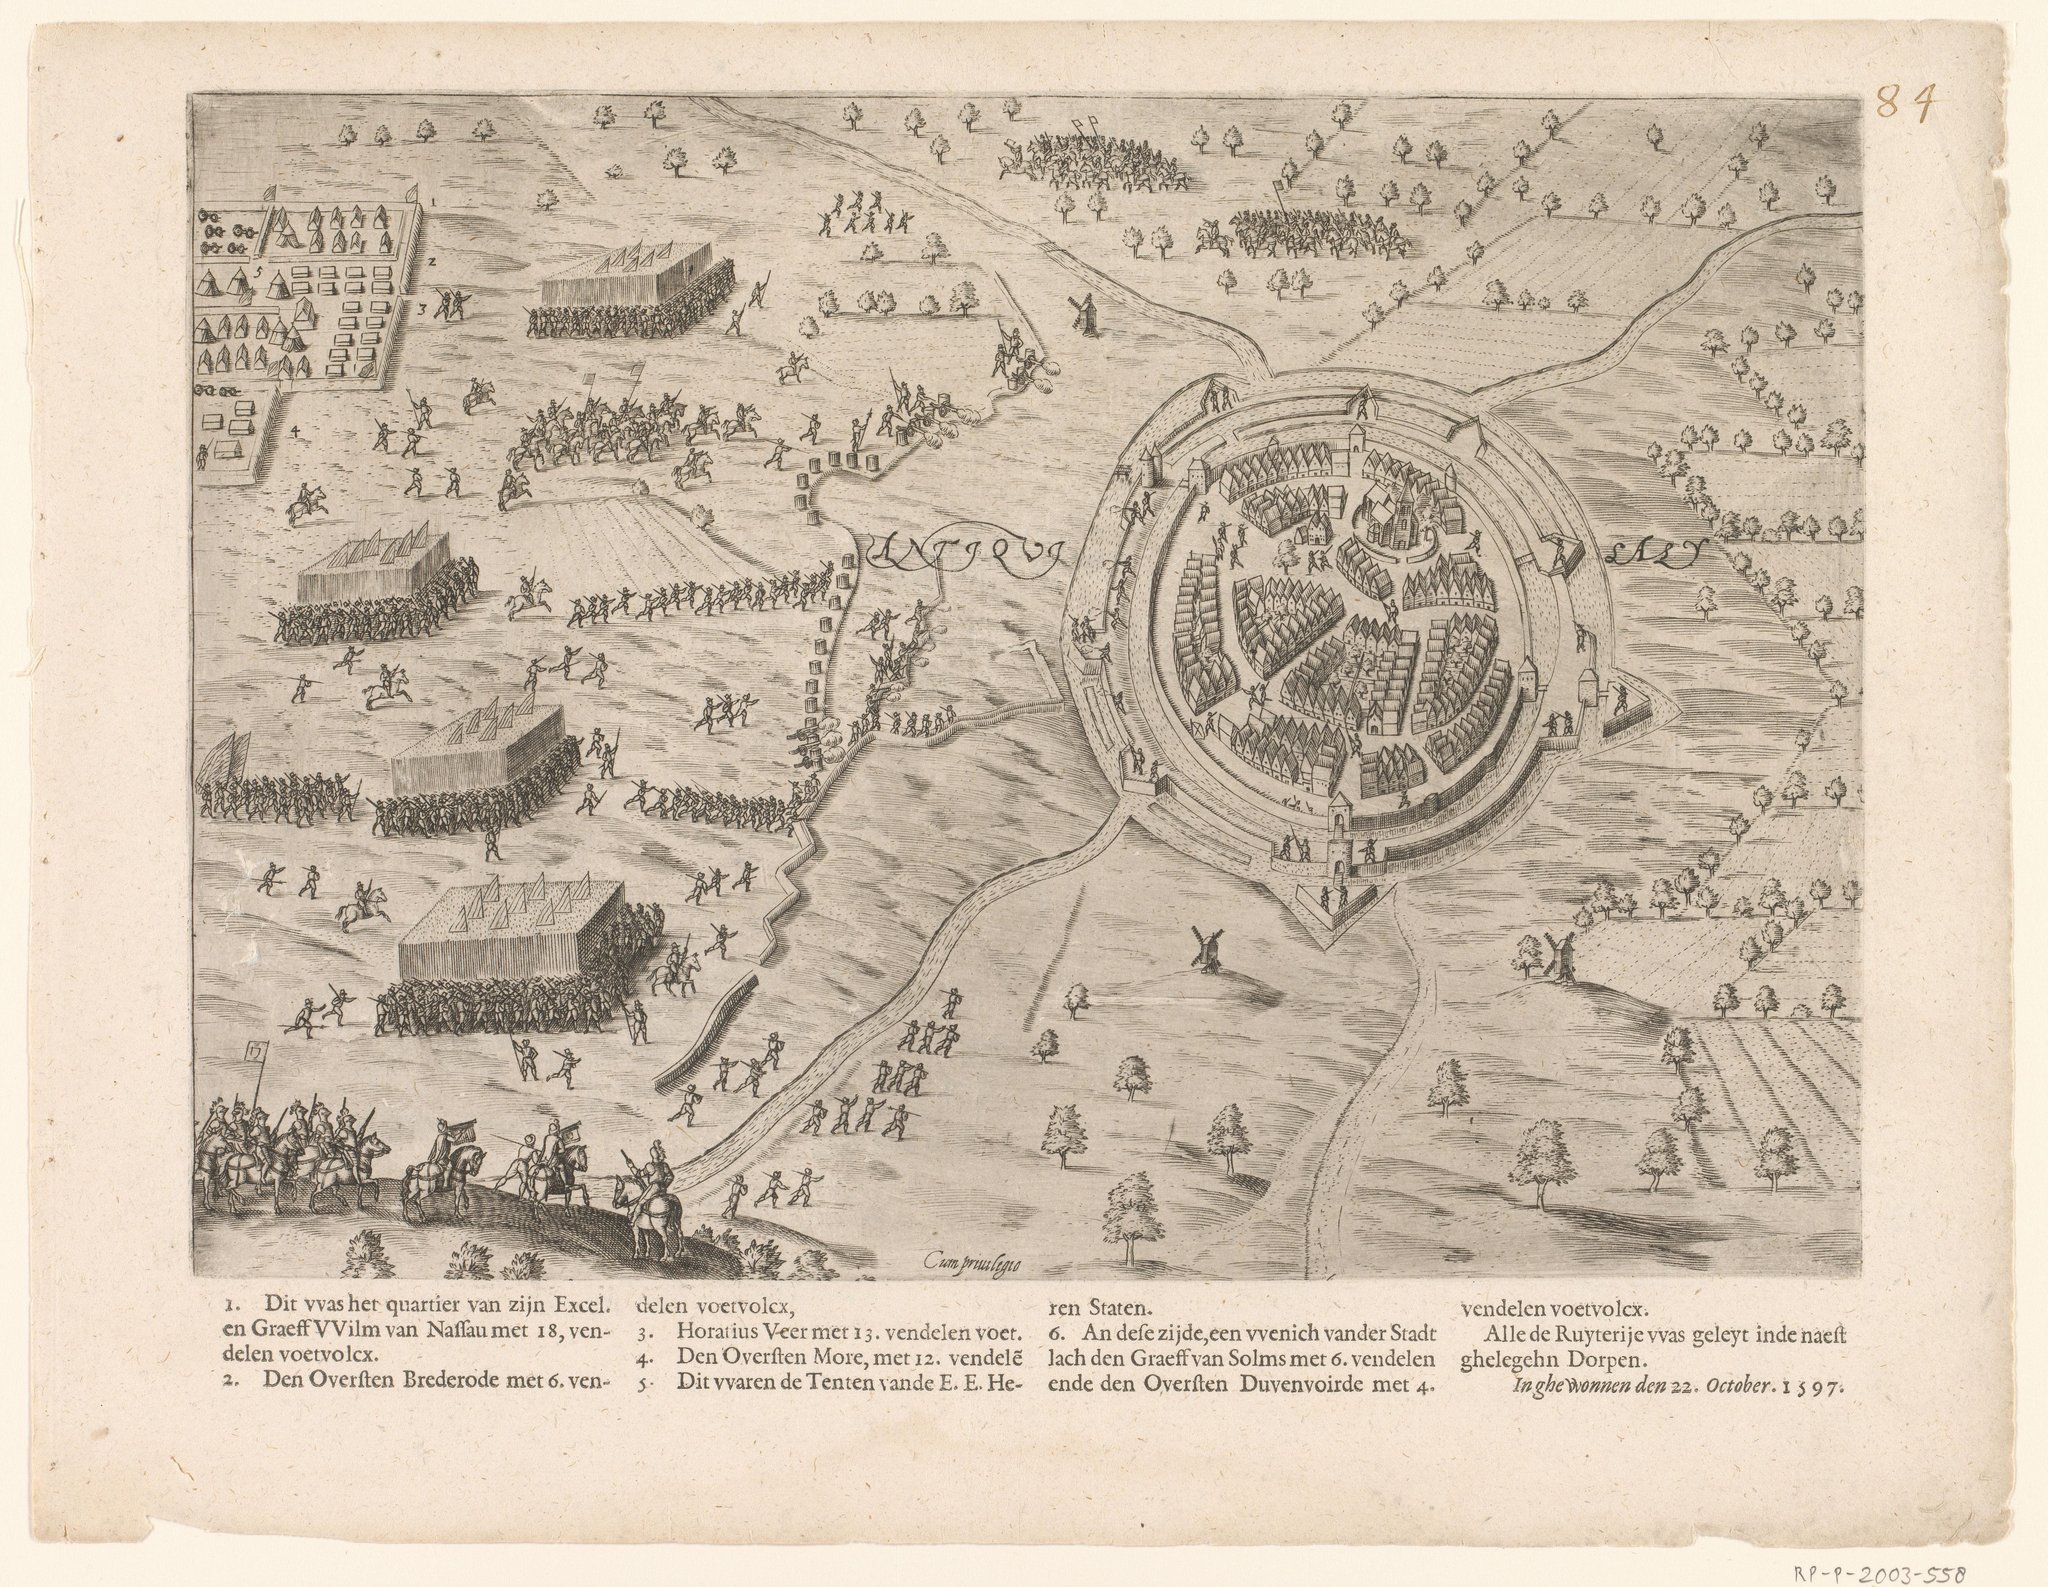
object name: area plan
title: Antiquisasy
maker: pieter bast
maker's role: print maker, publisher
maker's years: 1570-1605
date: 1608-1610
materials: paper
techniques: engraving, letterpress printing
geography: northern netherlands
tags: the hague, maurice (prince of orange), capture of city (after the siege), maps of cities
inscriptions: number: ‘84’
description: Verovering van Oldenzaal door het Staatse leger onder prins Maurits, 22 oktober 1597. Plan van de stad en omgeving met links het oprukkende Staatse leger. Apart gedrukt onder de plaat de legenda 1-6 in vier kolommen in het Nederlands. Aan het eind van de tekst het opschrift 'In ghe wonnen den 22 . October. 1597'. Onderdeel van de verzameling kaarten genomen uit een latere editie van: Descrittione di tutti i Paesi Bassi van Lodovico Guicciardini.